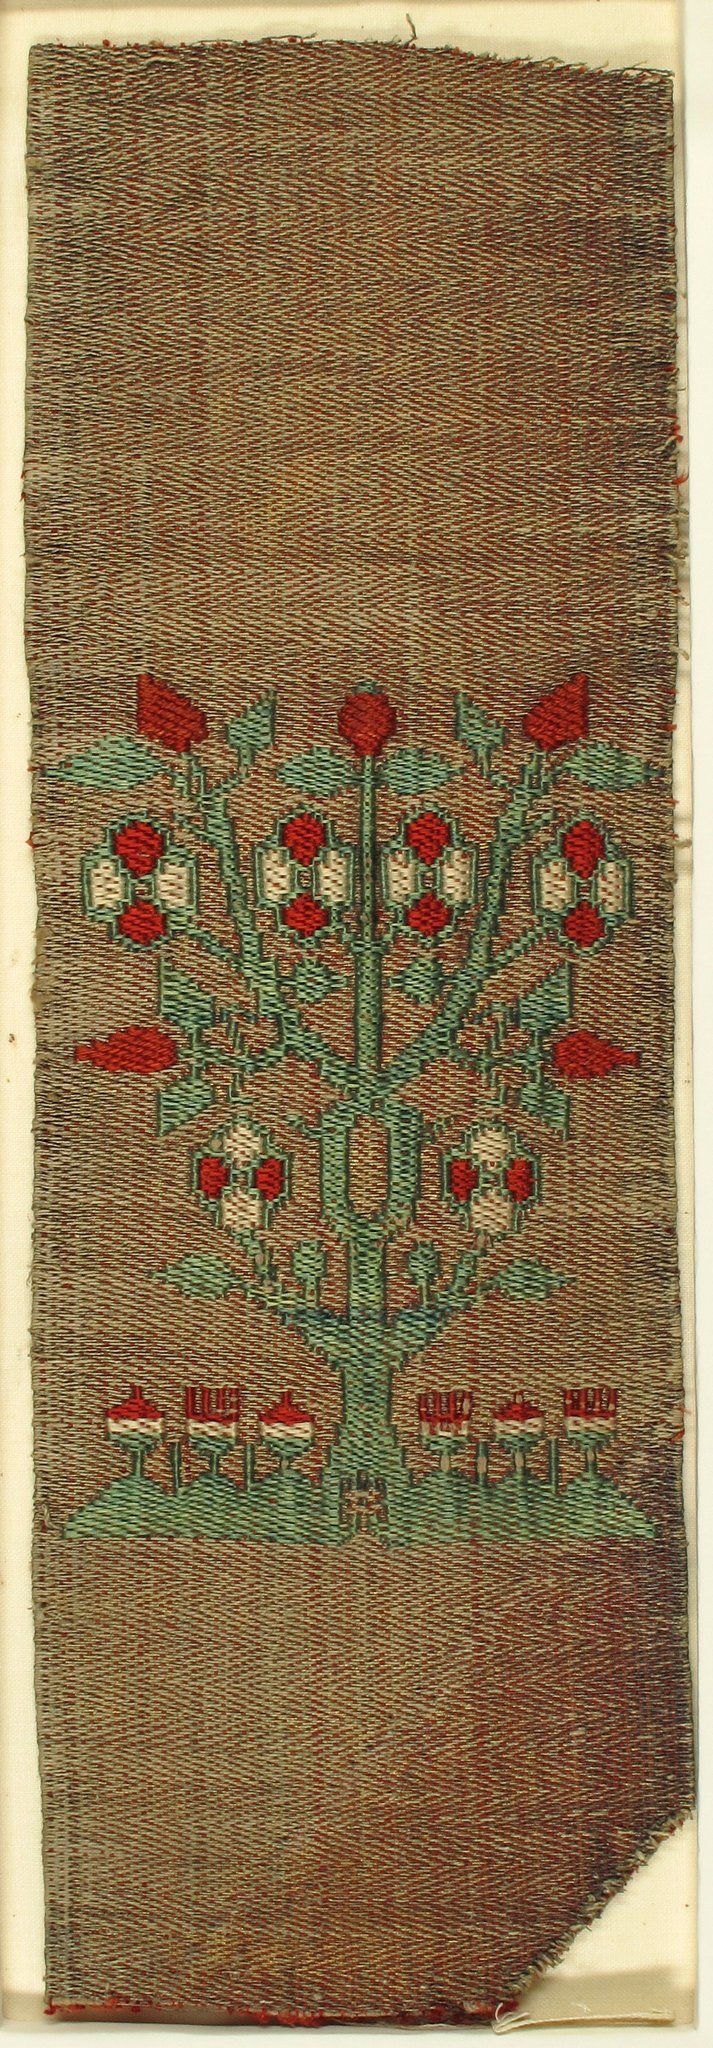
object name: textile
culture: german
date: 1401-1500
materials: linen, metal thread, silk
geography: germany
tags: flowers